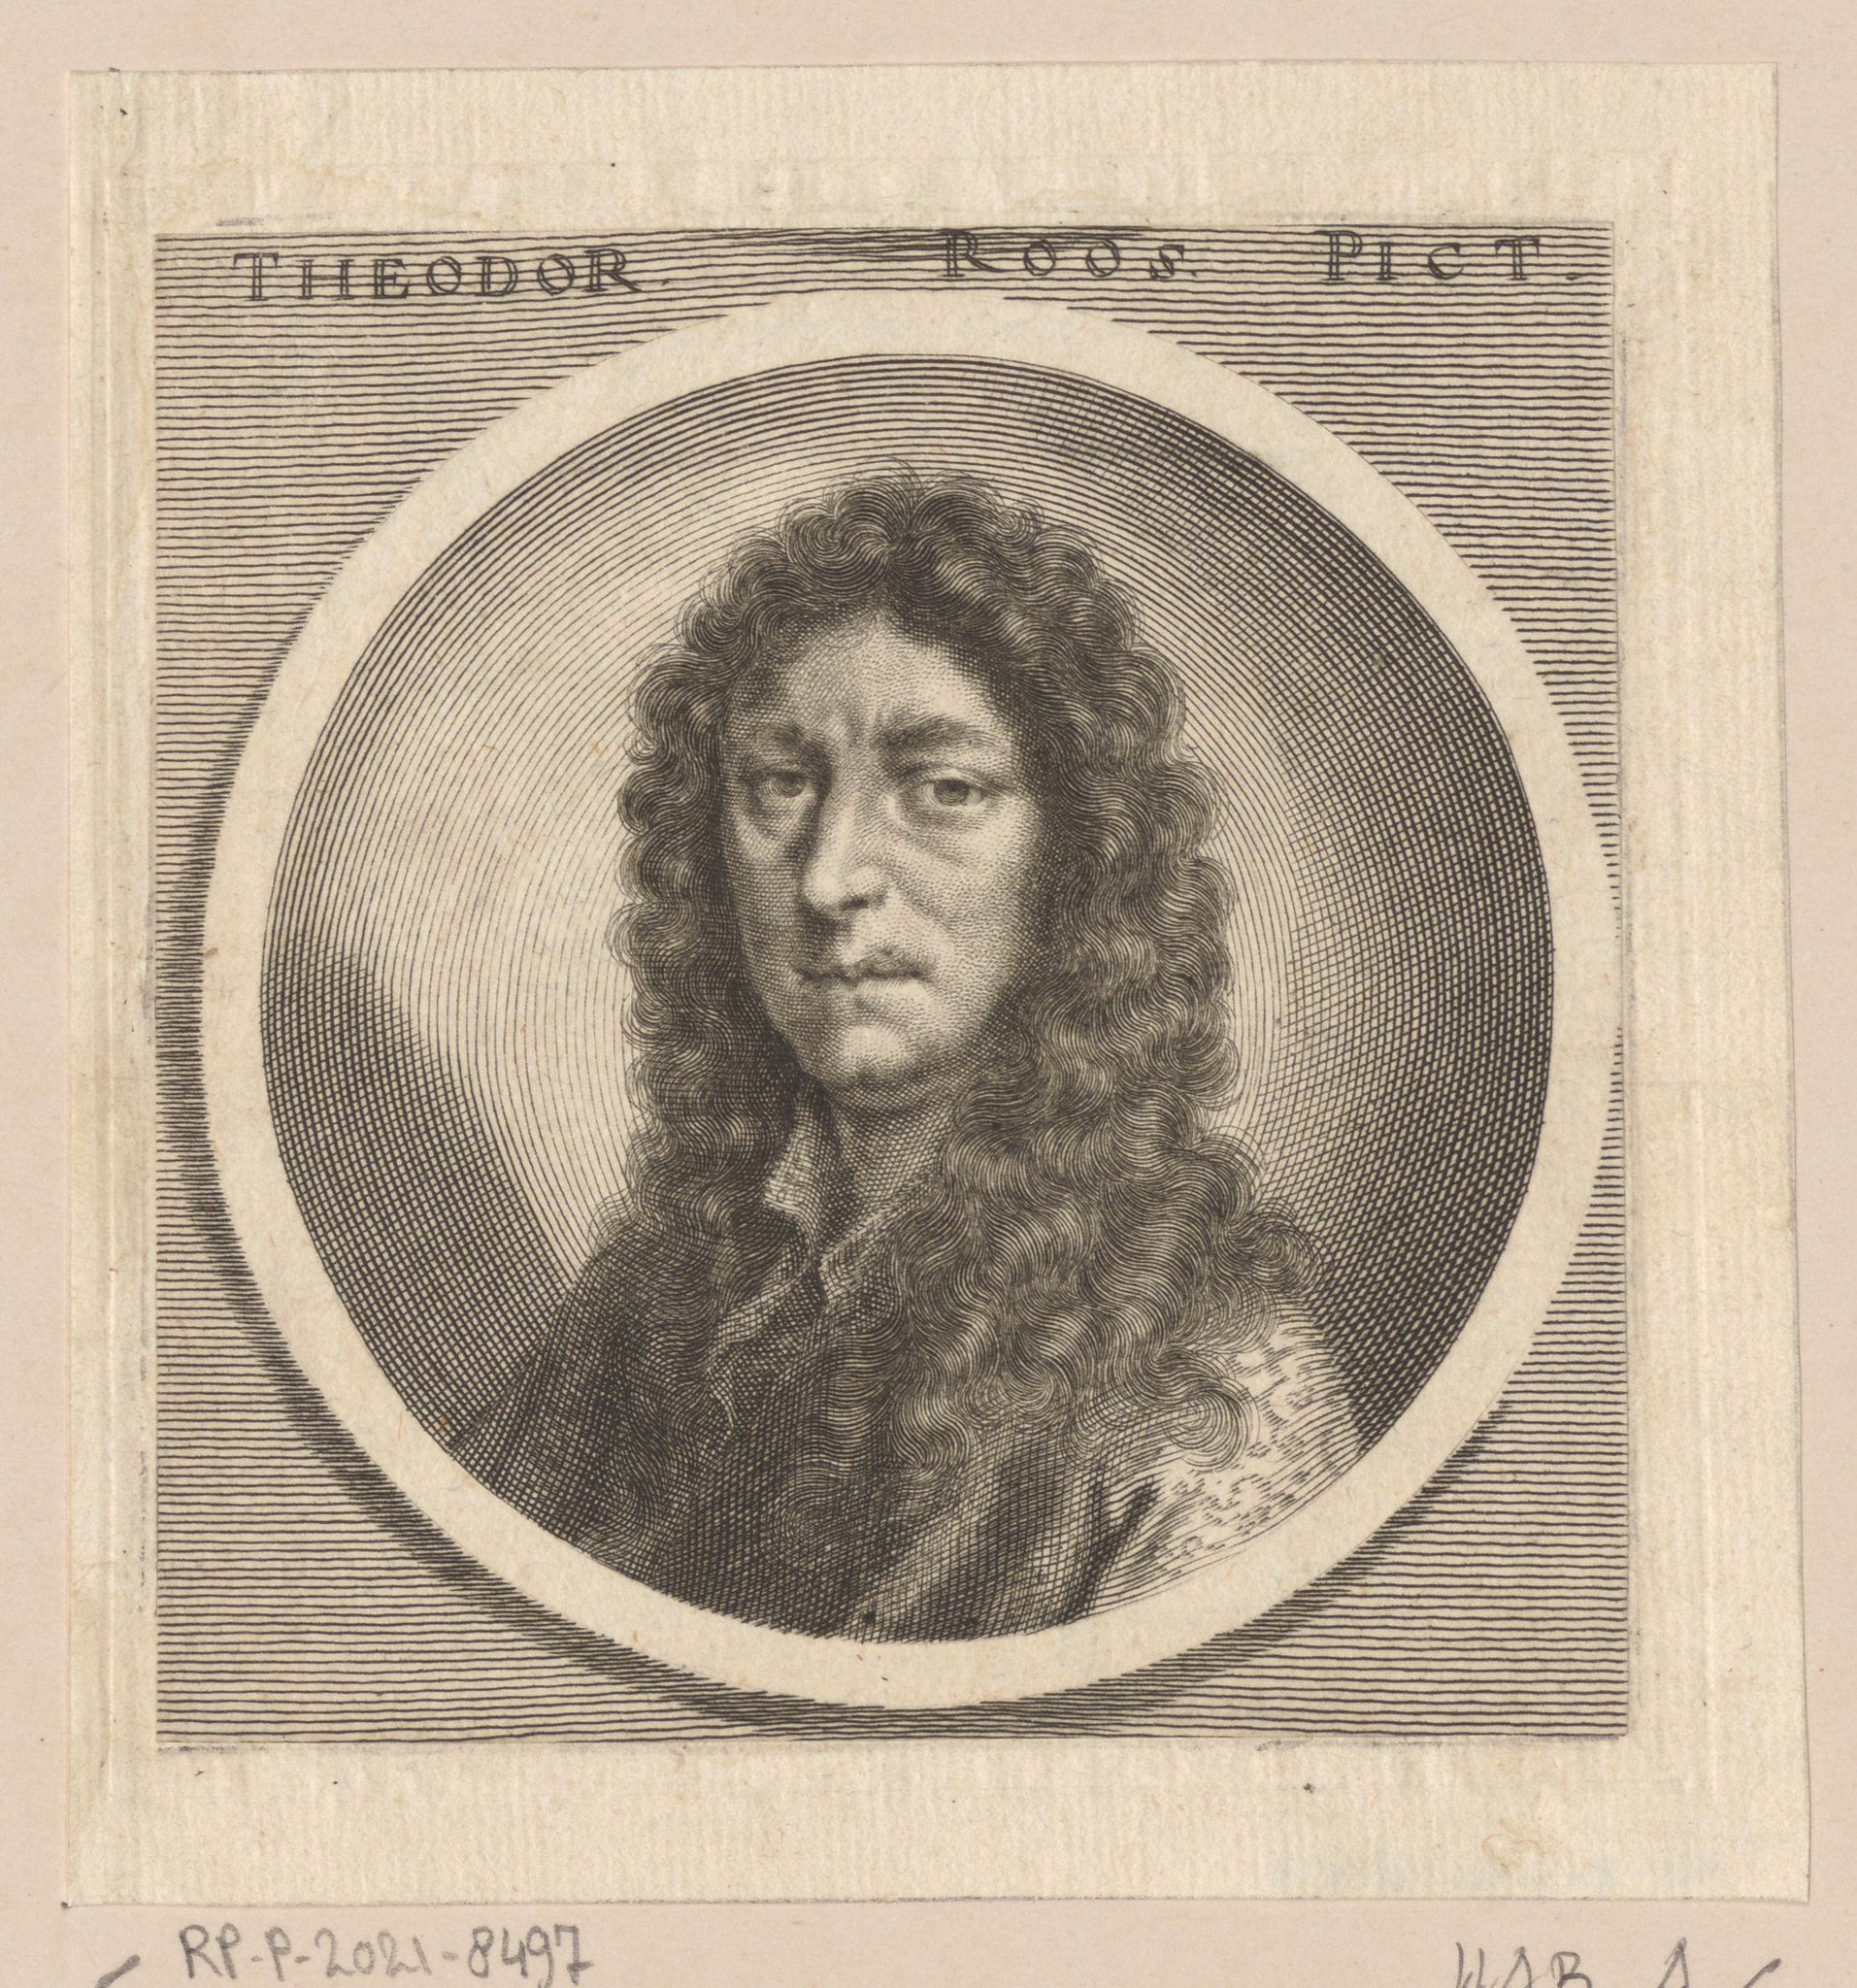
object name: print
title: Portret van Theodor Roos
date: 1683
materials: paper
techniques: engraving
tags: painter, theodor roos, historical persons, portrait, self-portrait of painter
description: Prent mogelijk uit: Sandrart, Joachim. Academia nobilissimae artis pictoriae sive de veris (...). Neurenberg: Christian Sigismund Froberg, 1683.